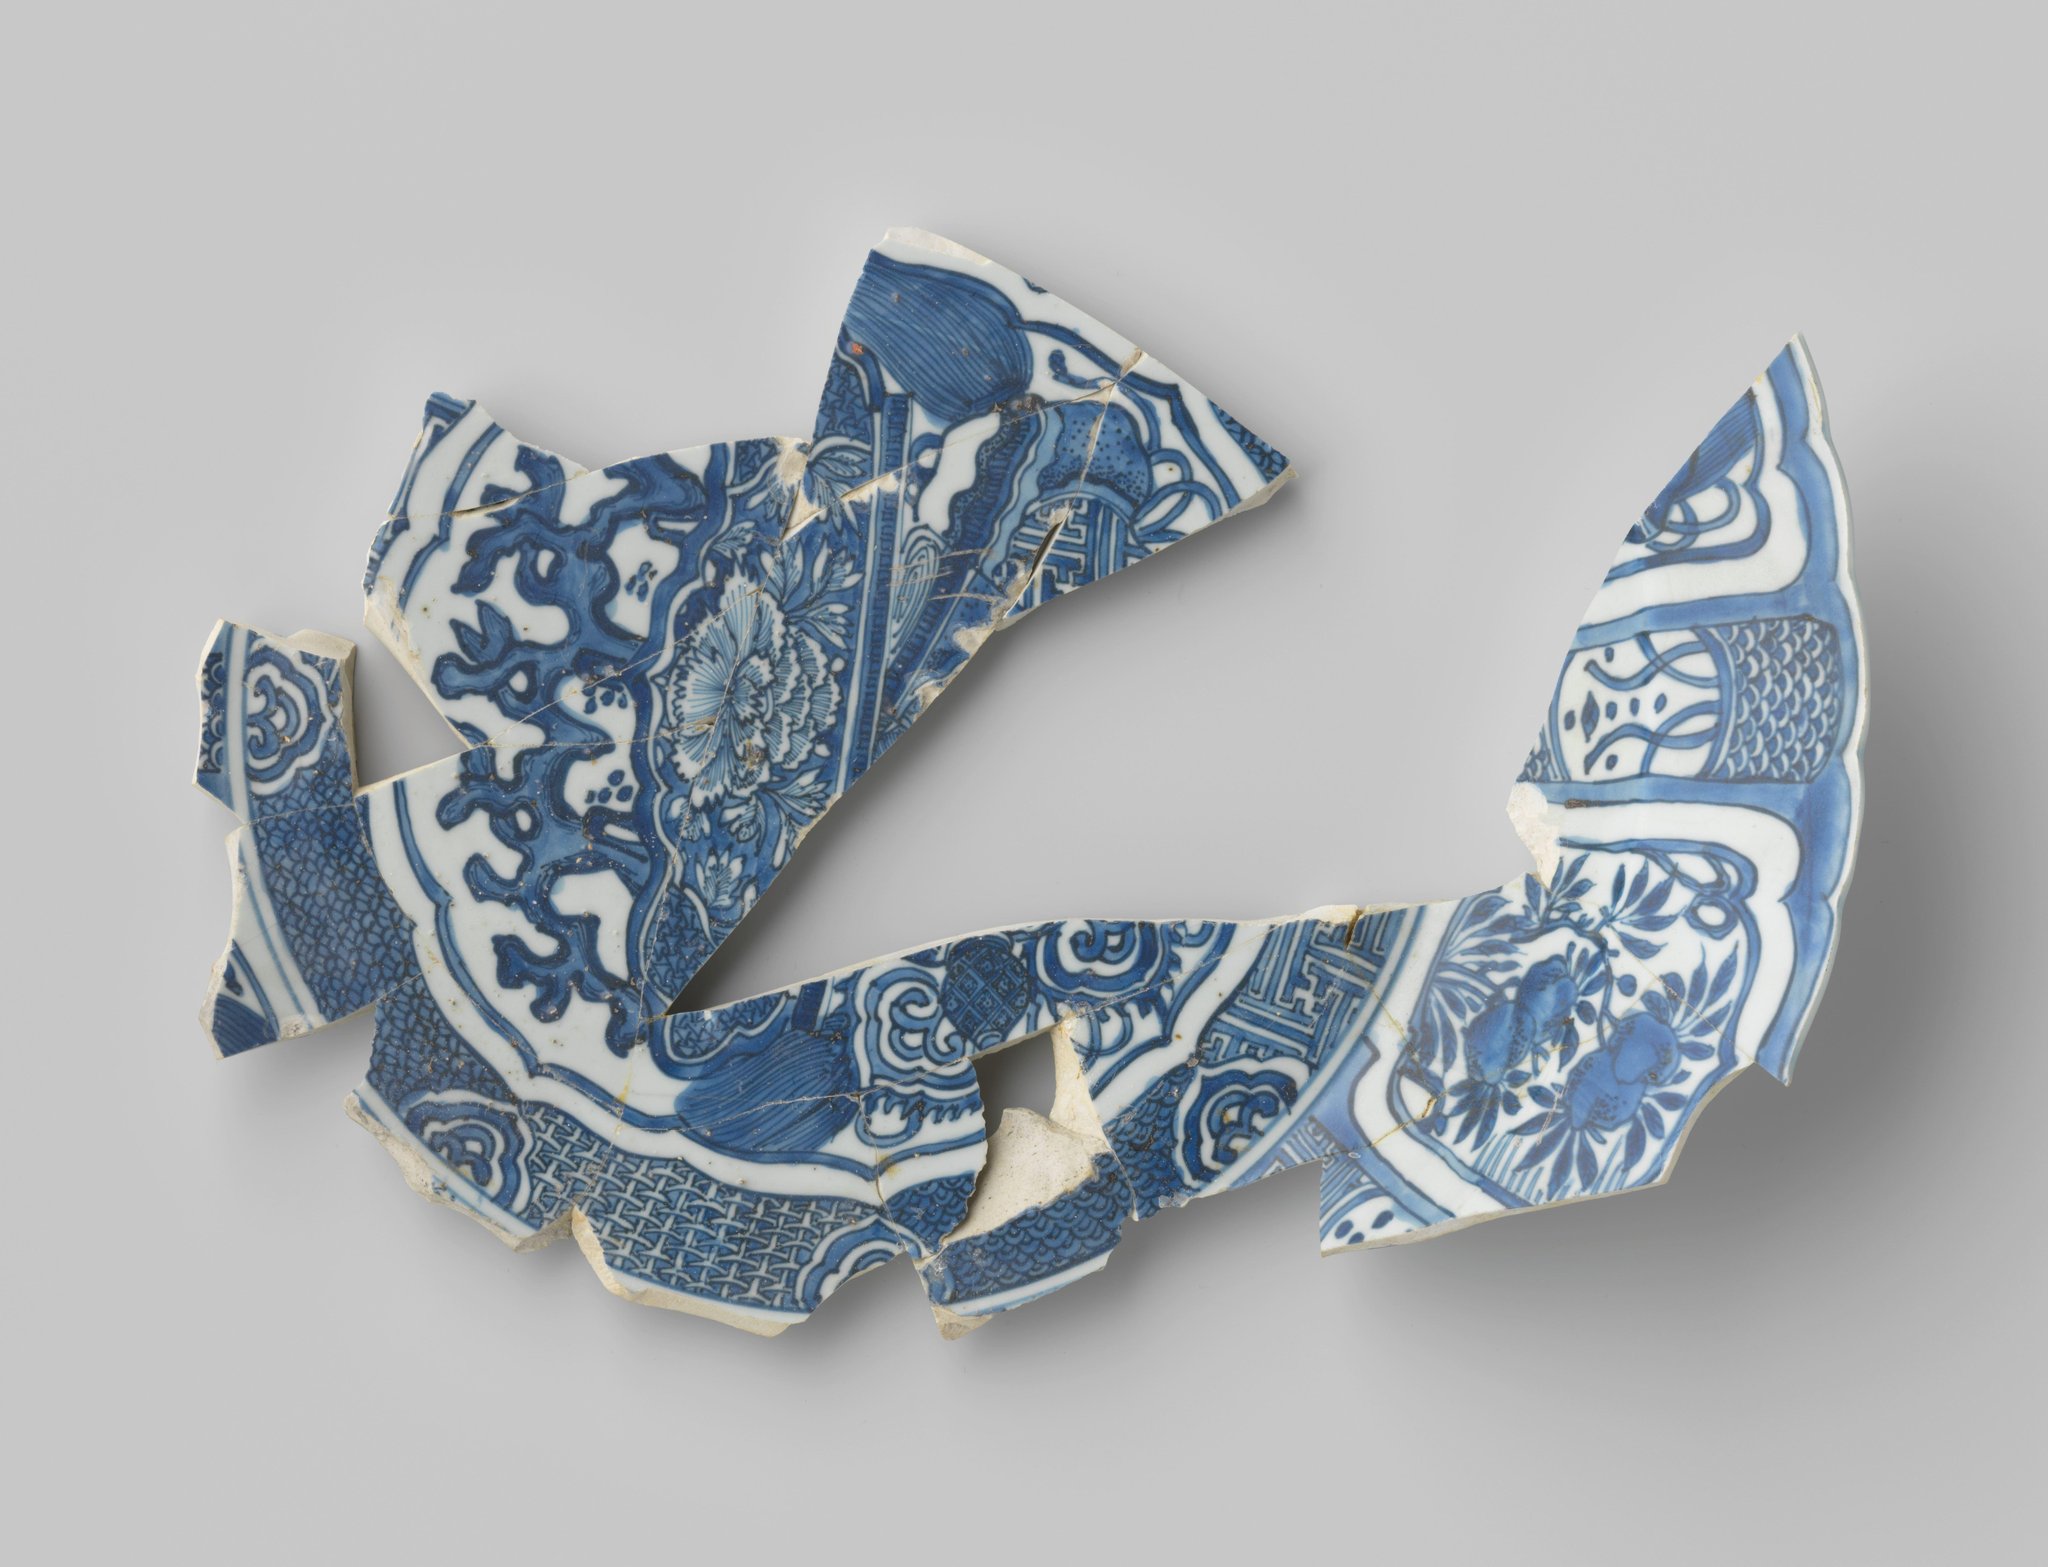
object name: sherd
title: Fragment schotel uit V.O.C.-schip de 'Witte Leeuw'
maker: Anonymous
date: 1613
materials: bone china, glaze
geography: jingdezhen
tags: verenigde oostindische compagnie, sint-helena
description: Fragment schotel uit V.O.C.-schip de 'Witte Leeuw', samen met NG-1978-127-1-B-W 40% aanwezig. De scherf is wit en kent weinig ingebakken vuil. Het glazuur is blauwgetint. De bodem is ongeglazuurd en heeft een gefacetteerde naar binnen staande voetring. Er is geen ovenzand aangetroffen. De lip is geschulpt. Lampetschotel. Achttien aan elkaar gelijmde fragmenten.